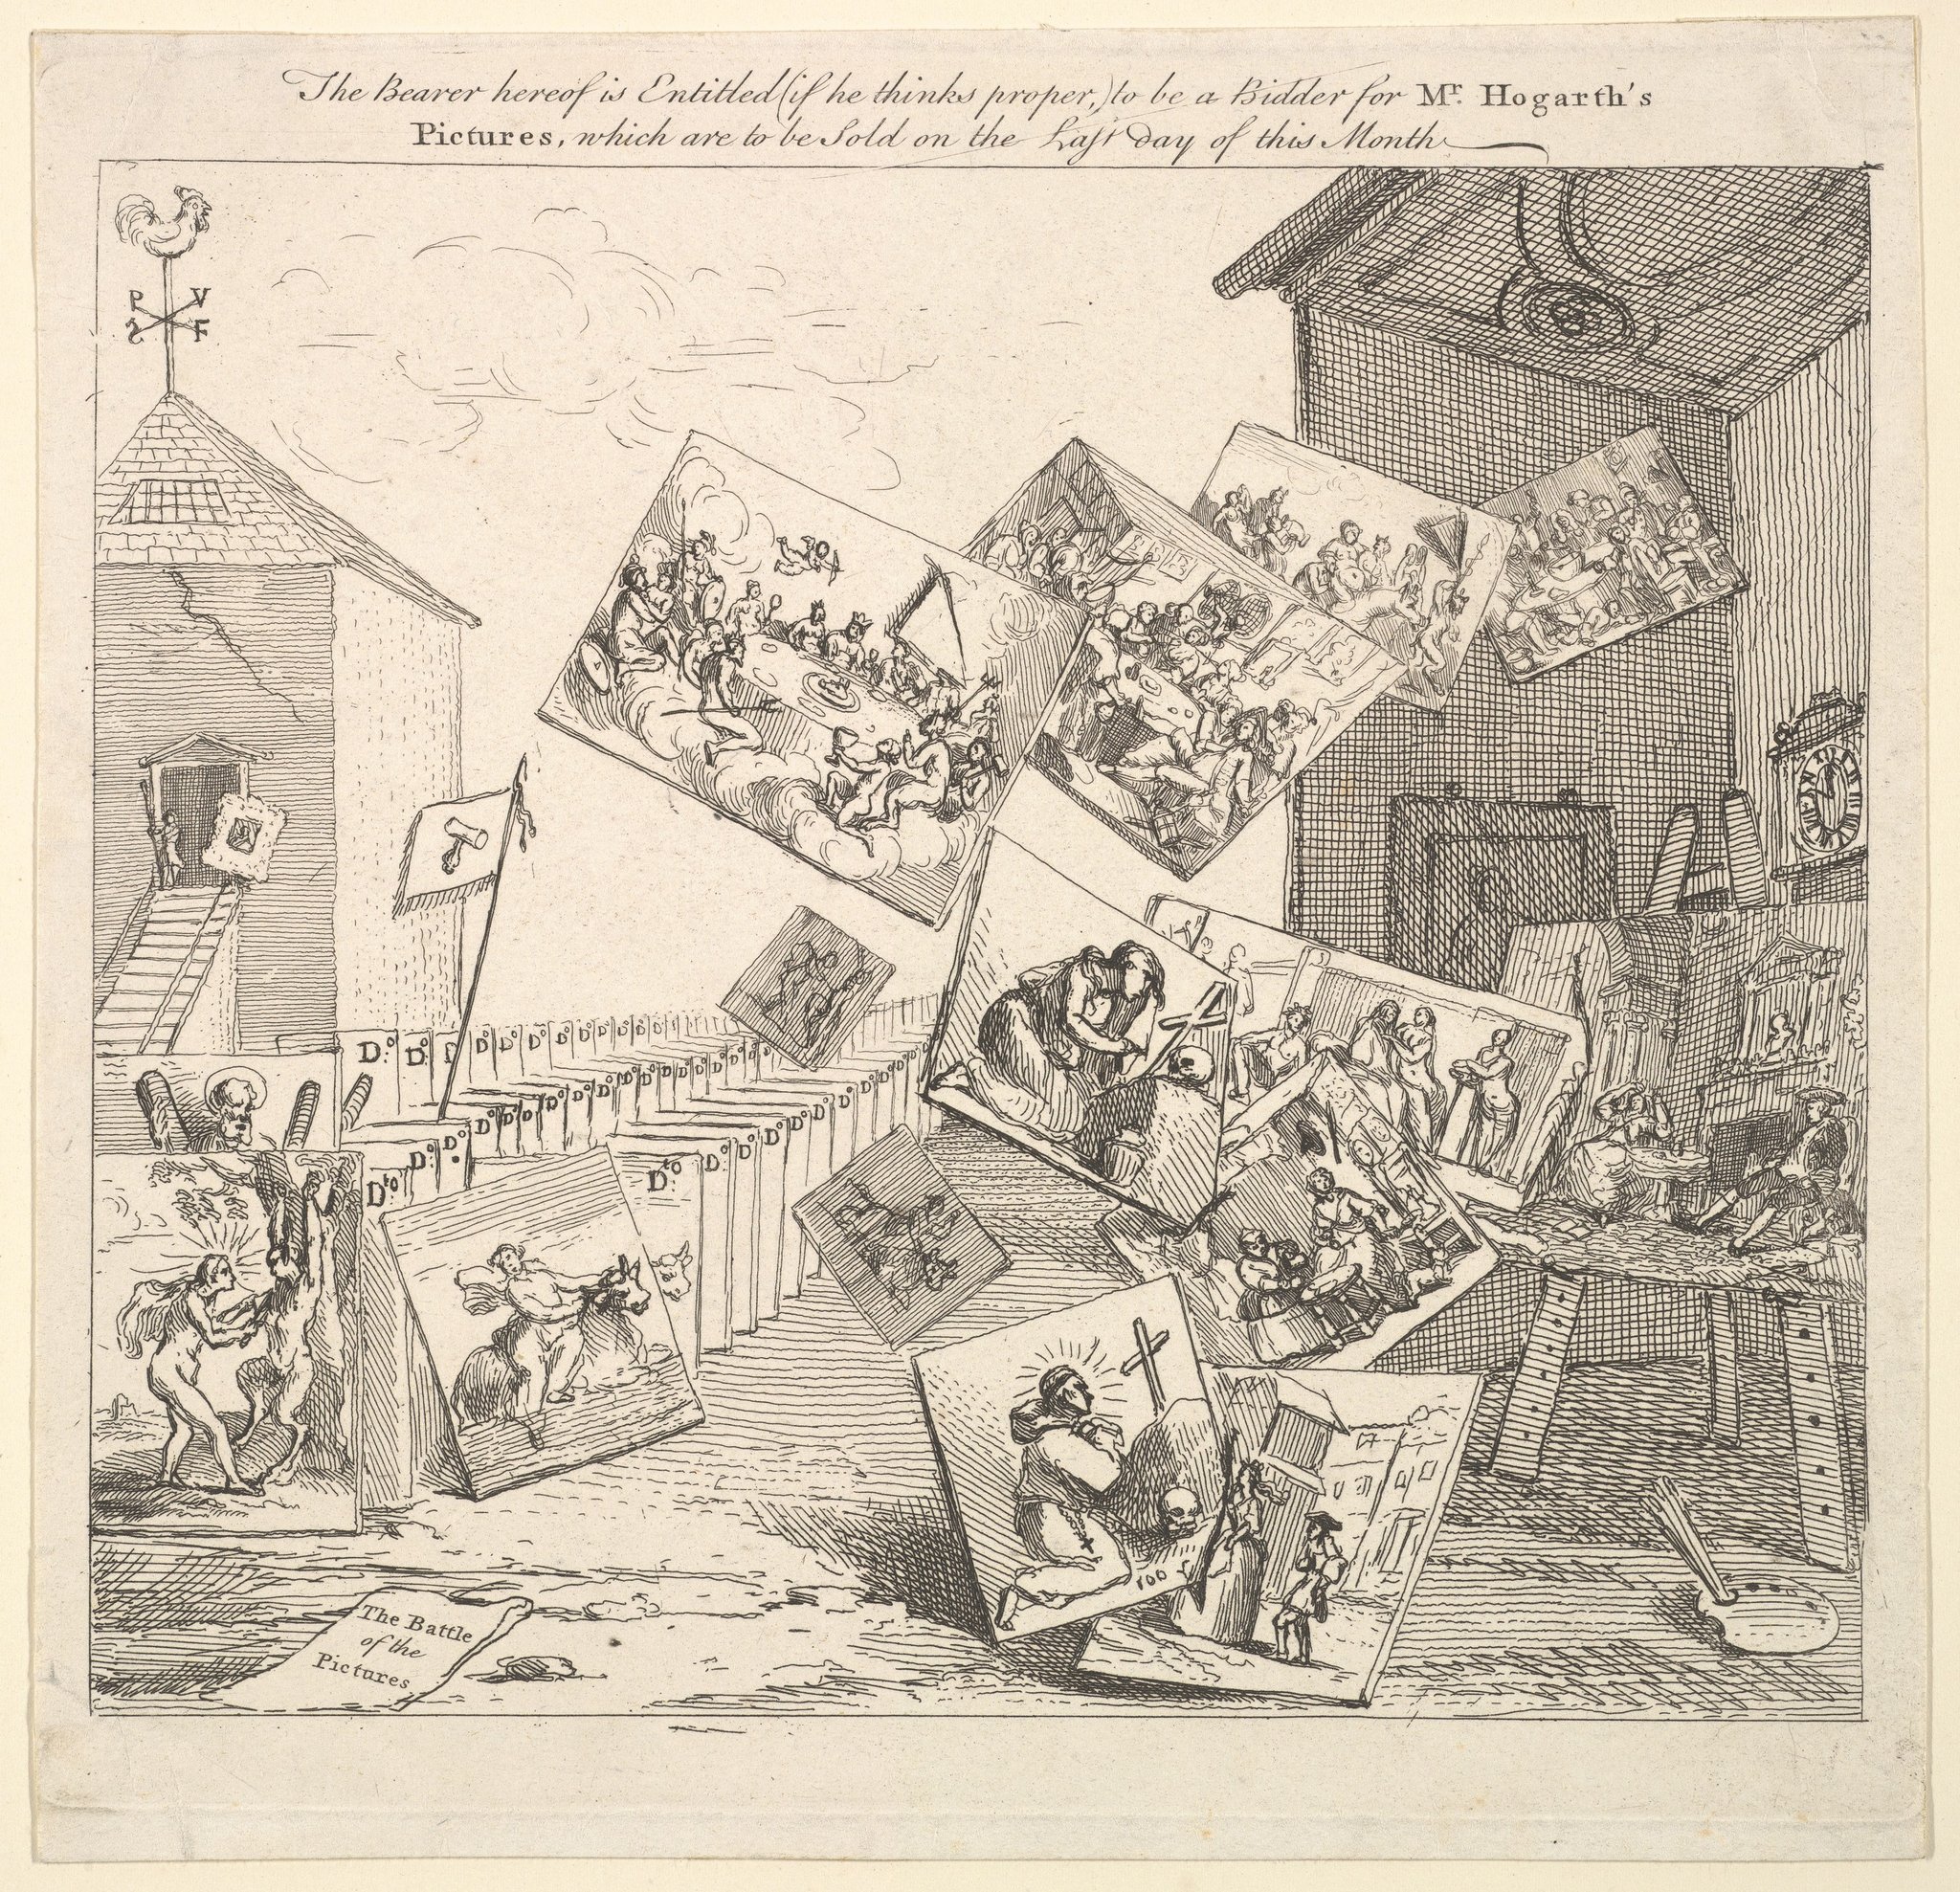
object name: print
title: The Battle of the Pictures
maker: william hogarth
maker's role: artist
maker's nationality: british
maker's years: 1697-1764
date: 1745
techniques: engraving, etching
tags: men,women,cross